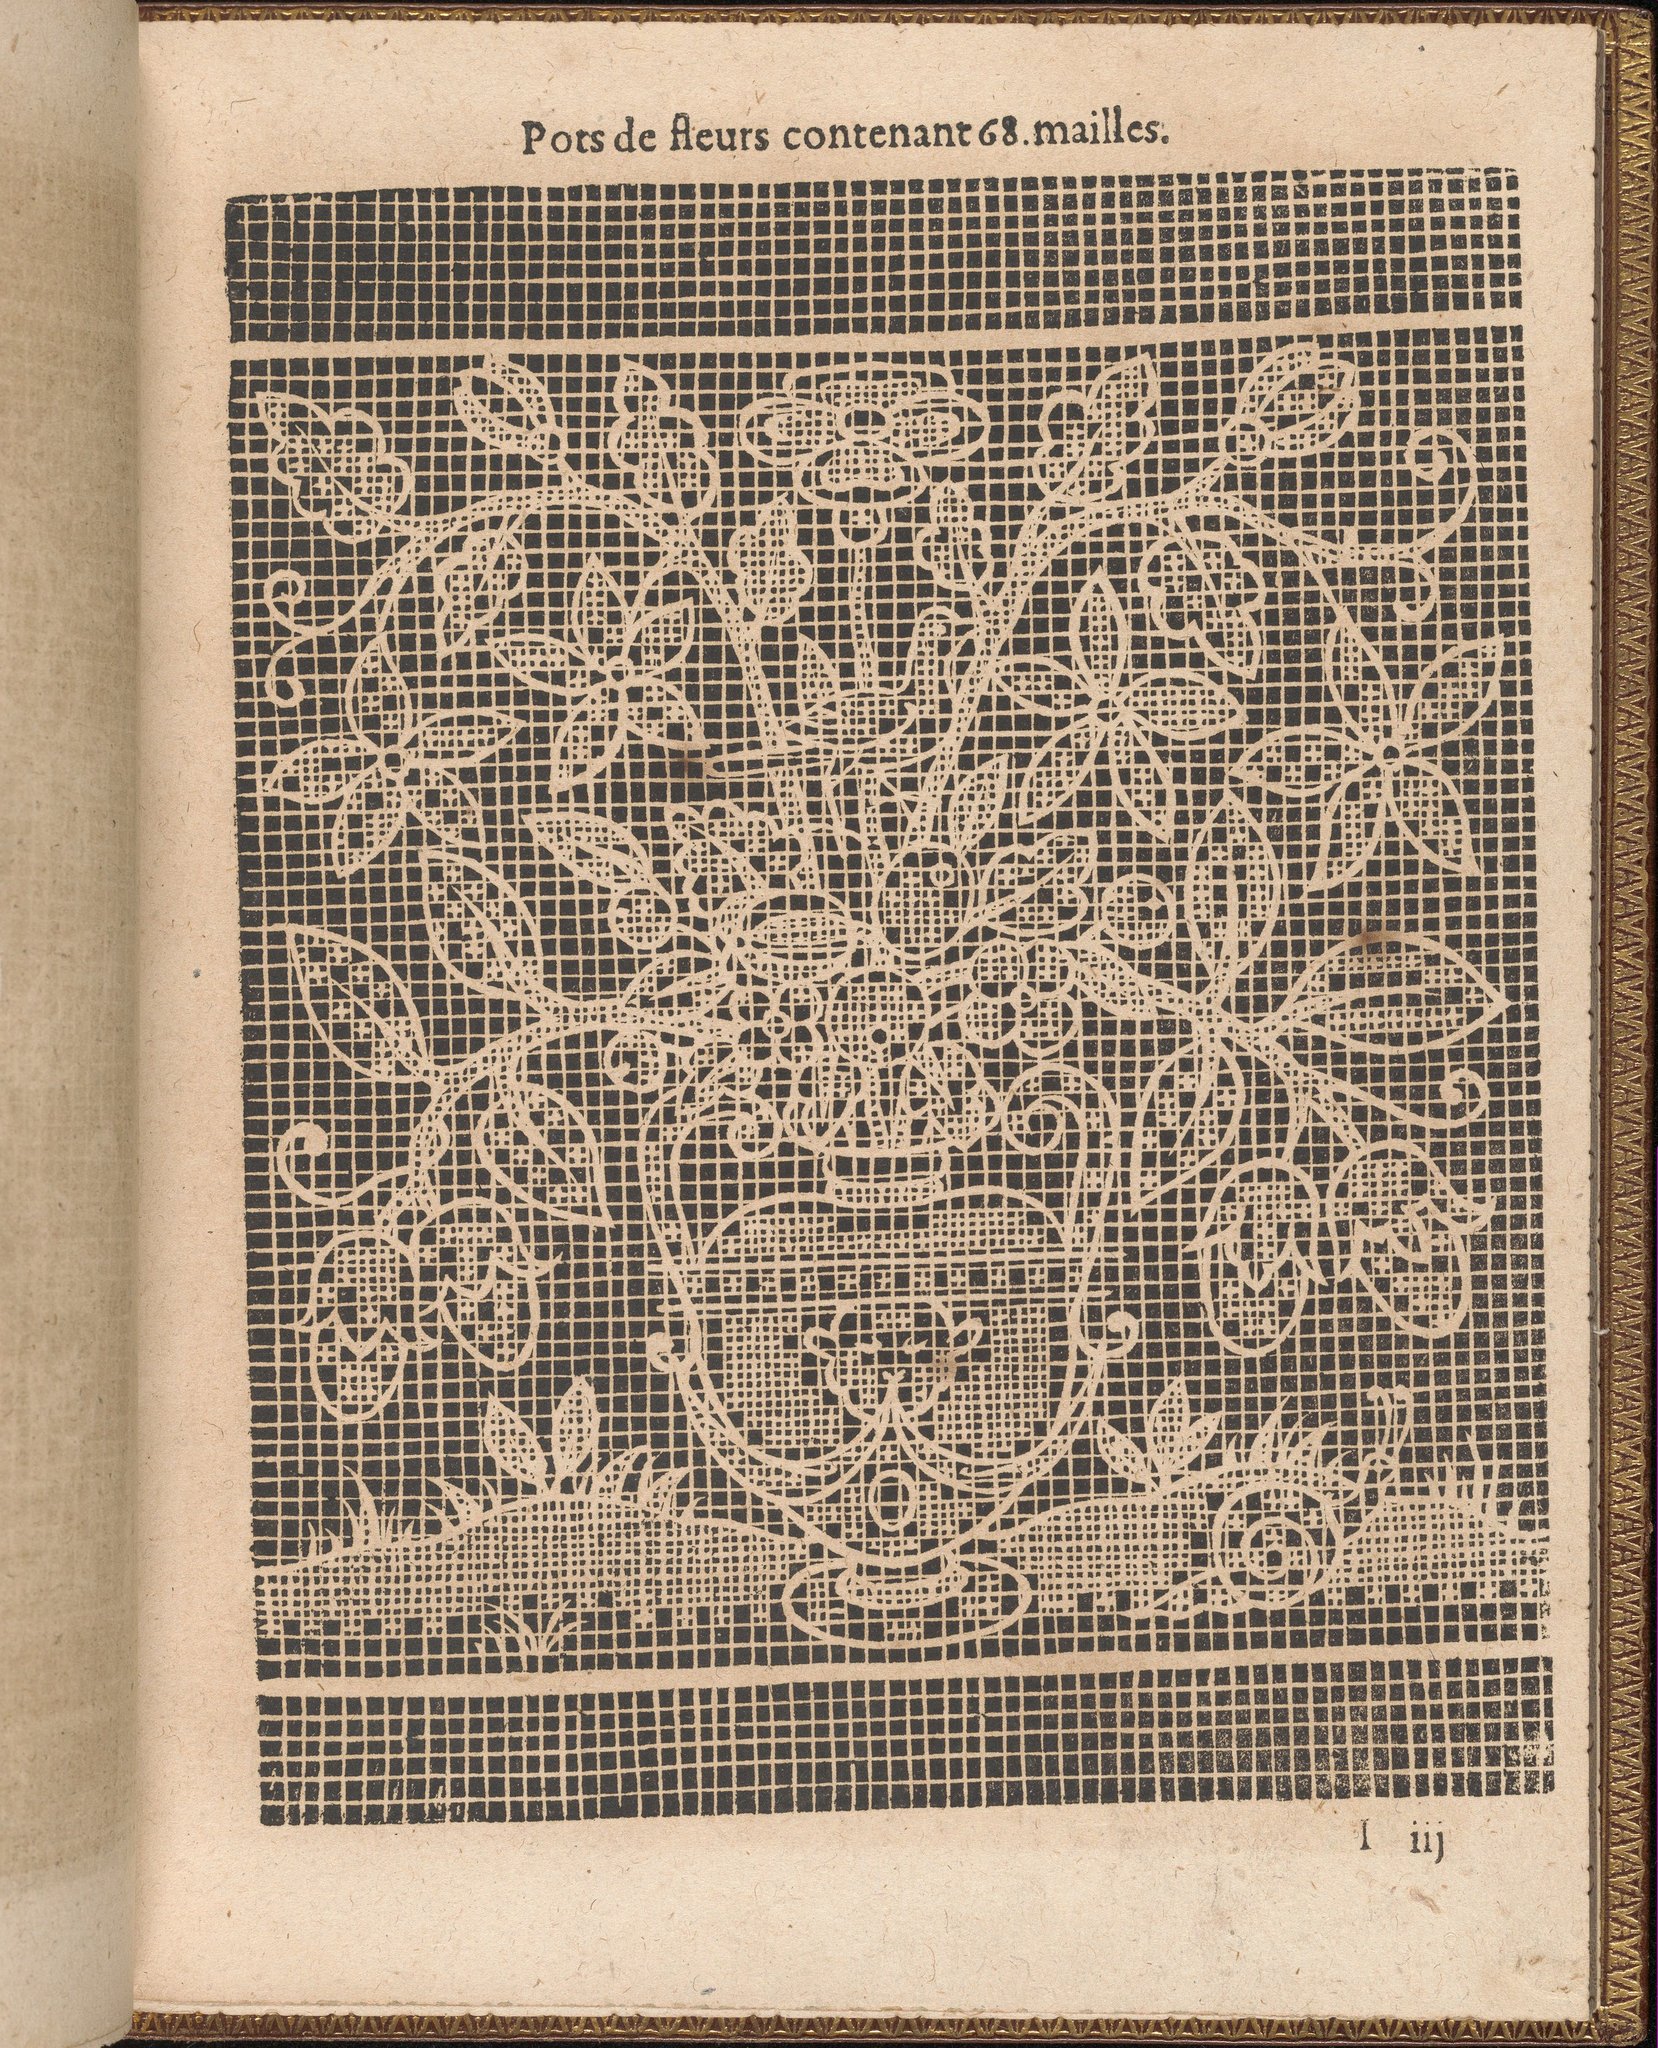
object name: book print ornament architecture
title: La Pratique de l'Aiguille, page 34 (recto)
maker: matthias mignerak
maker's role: author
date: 1605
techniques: woodcut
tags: snails,flowers